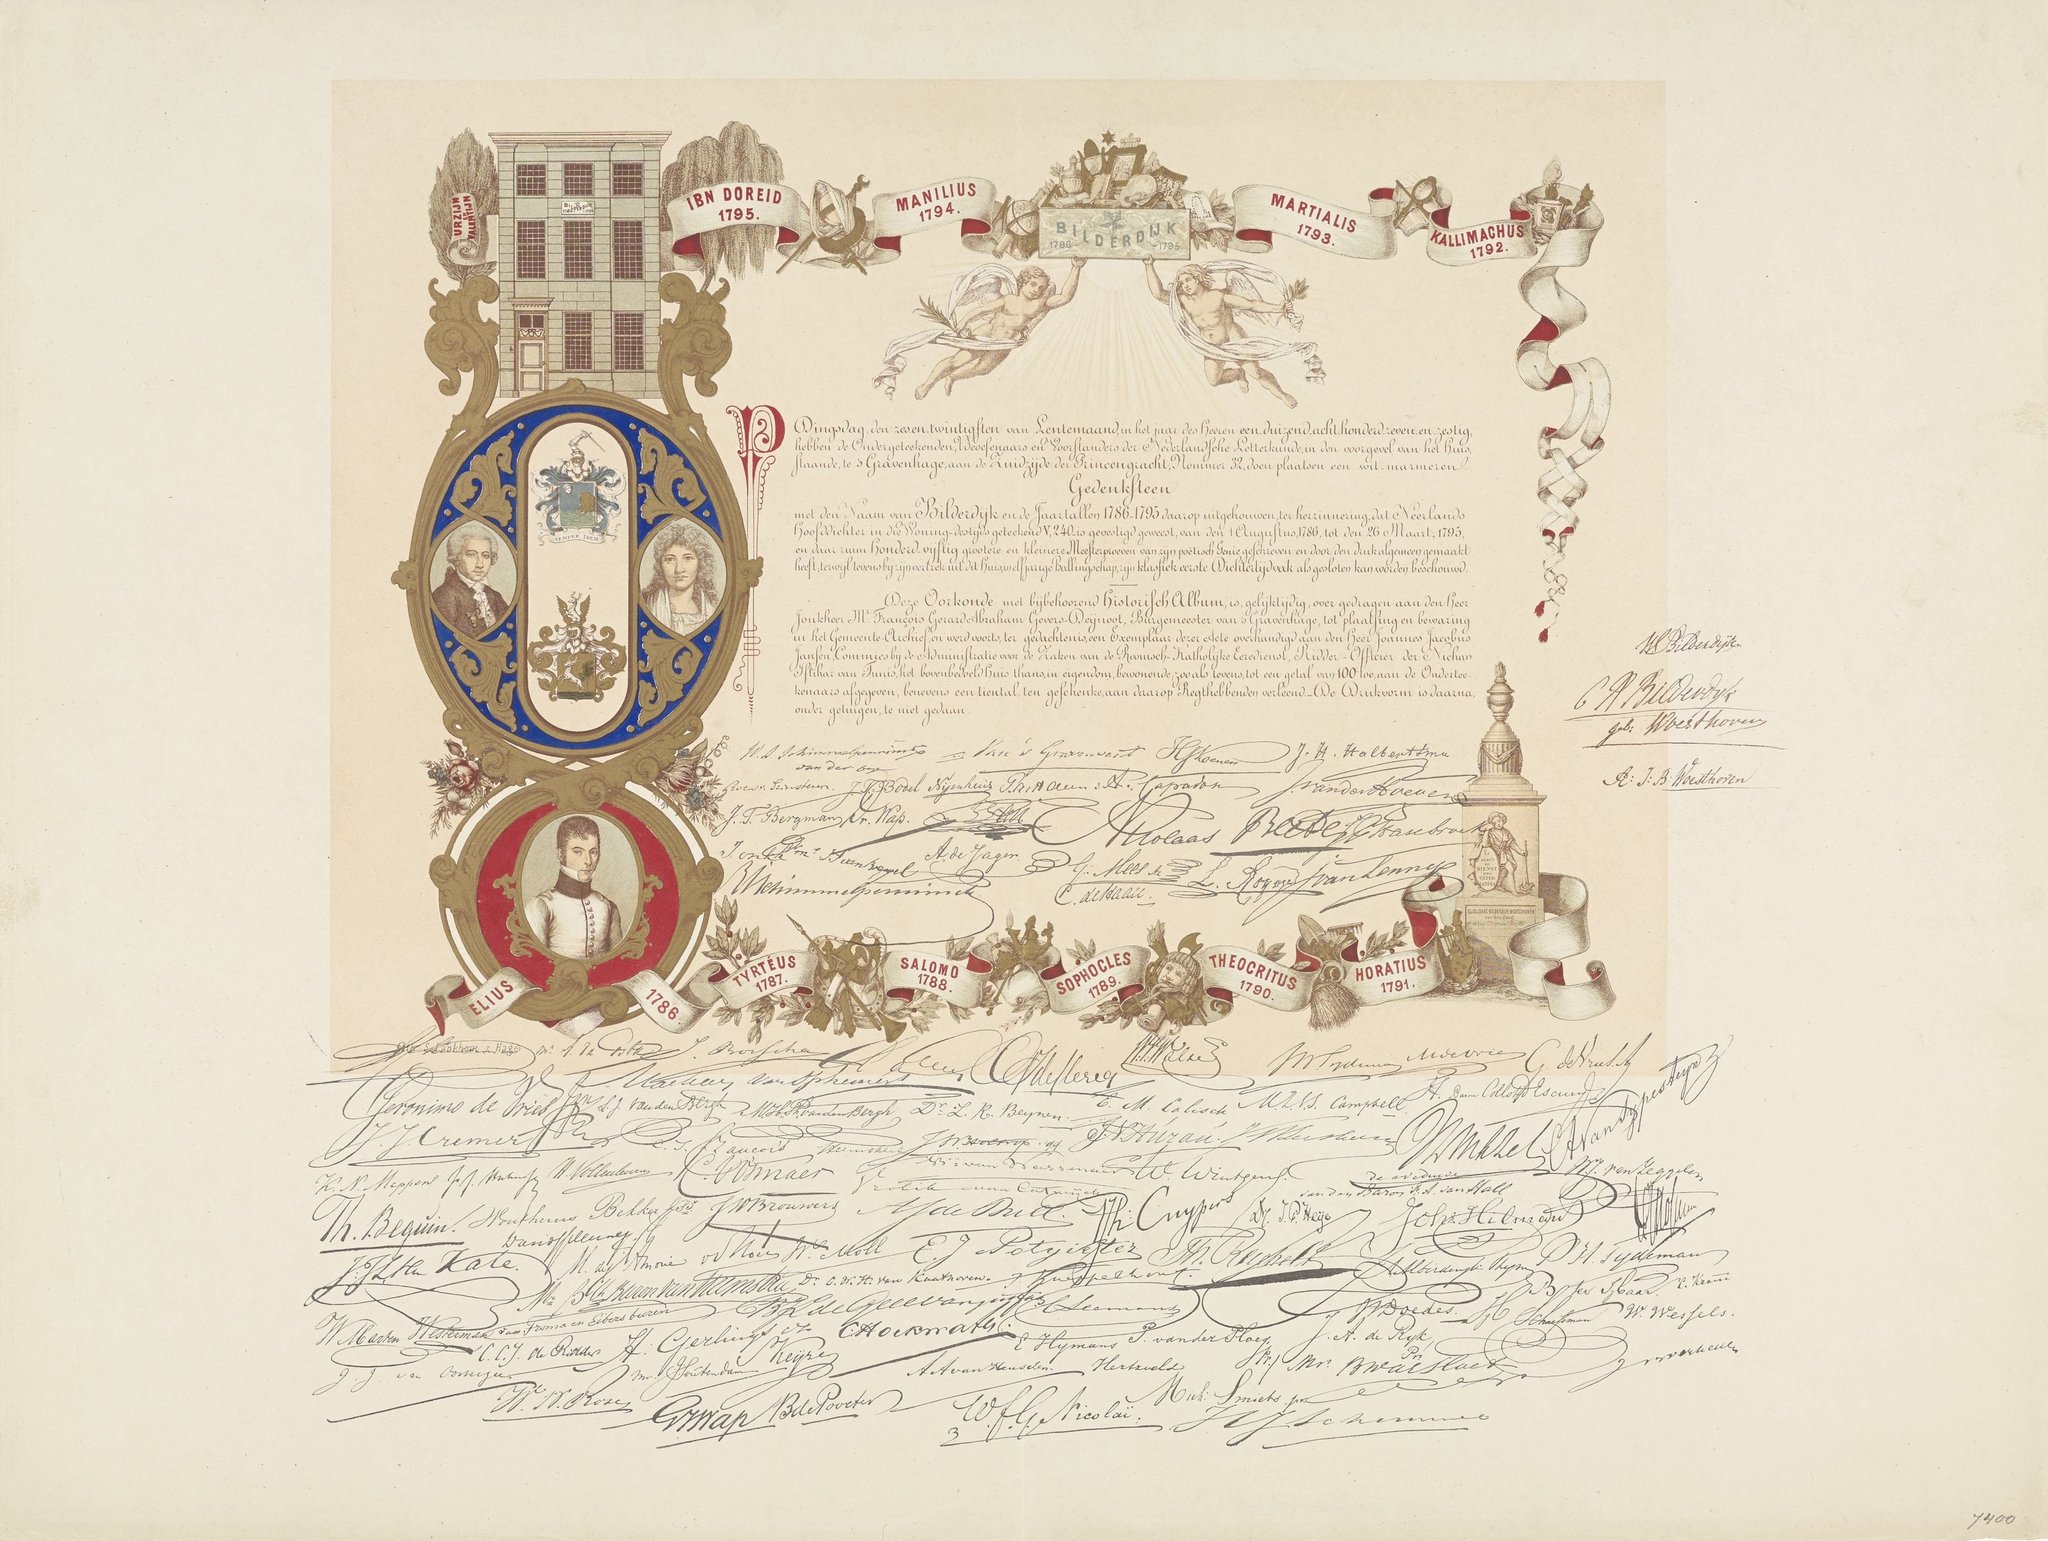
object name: print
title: Oorkonde ter gelegenheid van het inmetselen van een gedenksteen in het huis van Bilderdijk, 1867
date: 1867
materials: paper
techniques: lithograph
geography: the hague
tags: haarlem, print maker, draughtsman, willem bilderdijk, other memorial structures, the hague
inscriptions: collector's mark: Lugt 2228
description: Facsimile van de oorkonde uitgegeven ter gelegenheid van het inmetselen van een gedenksteen in het huis van Bilderdijk aan de Prinsengracht te Den Haag op 26 mei 1867. Onderaan de handtekeningen van ruim 100 Nederlandse letterkundigen.